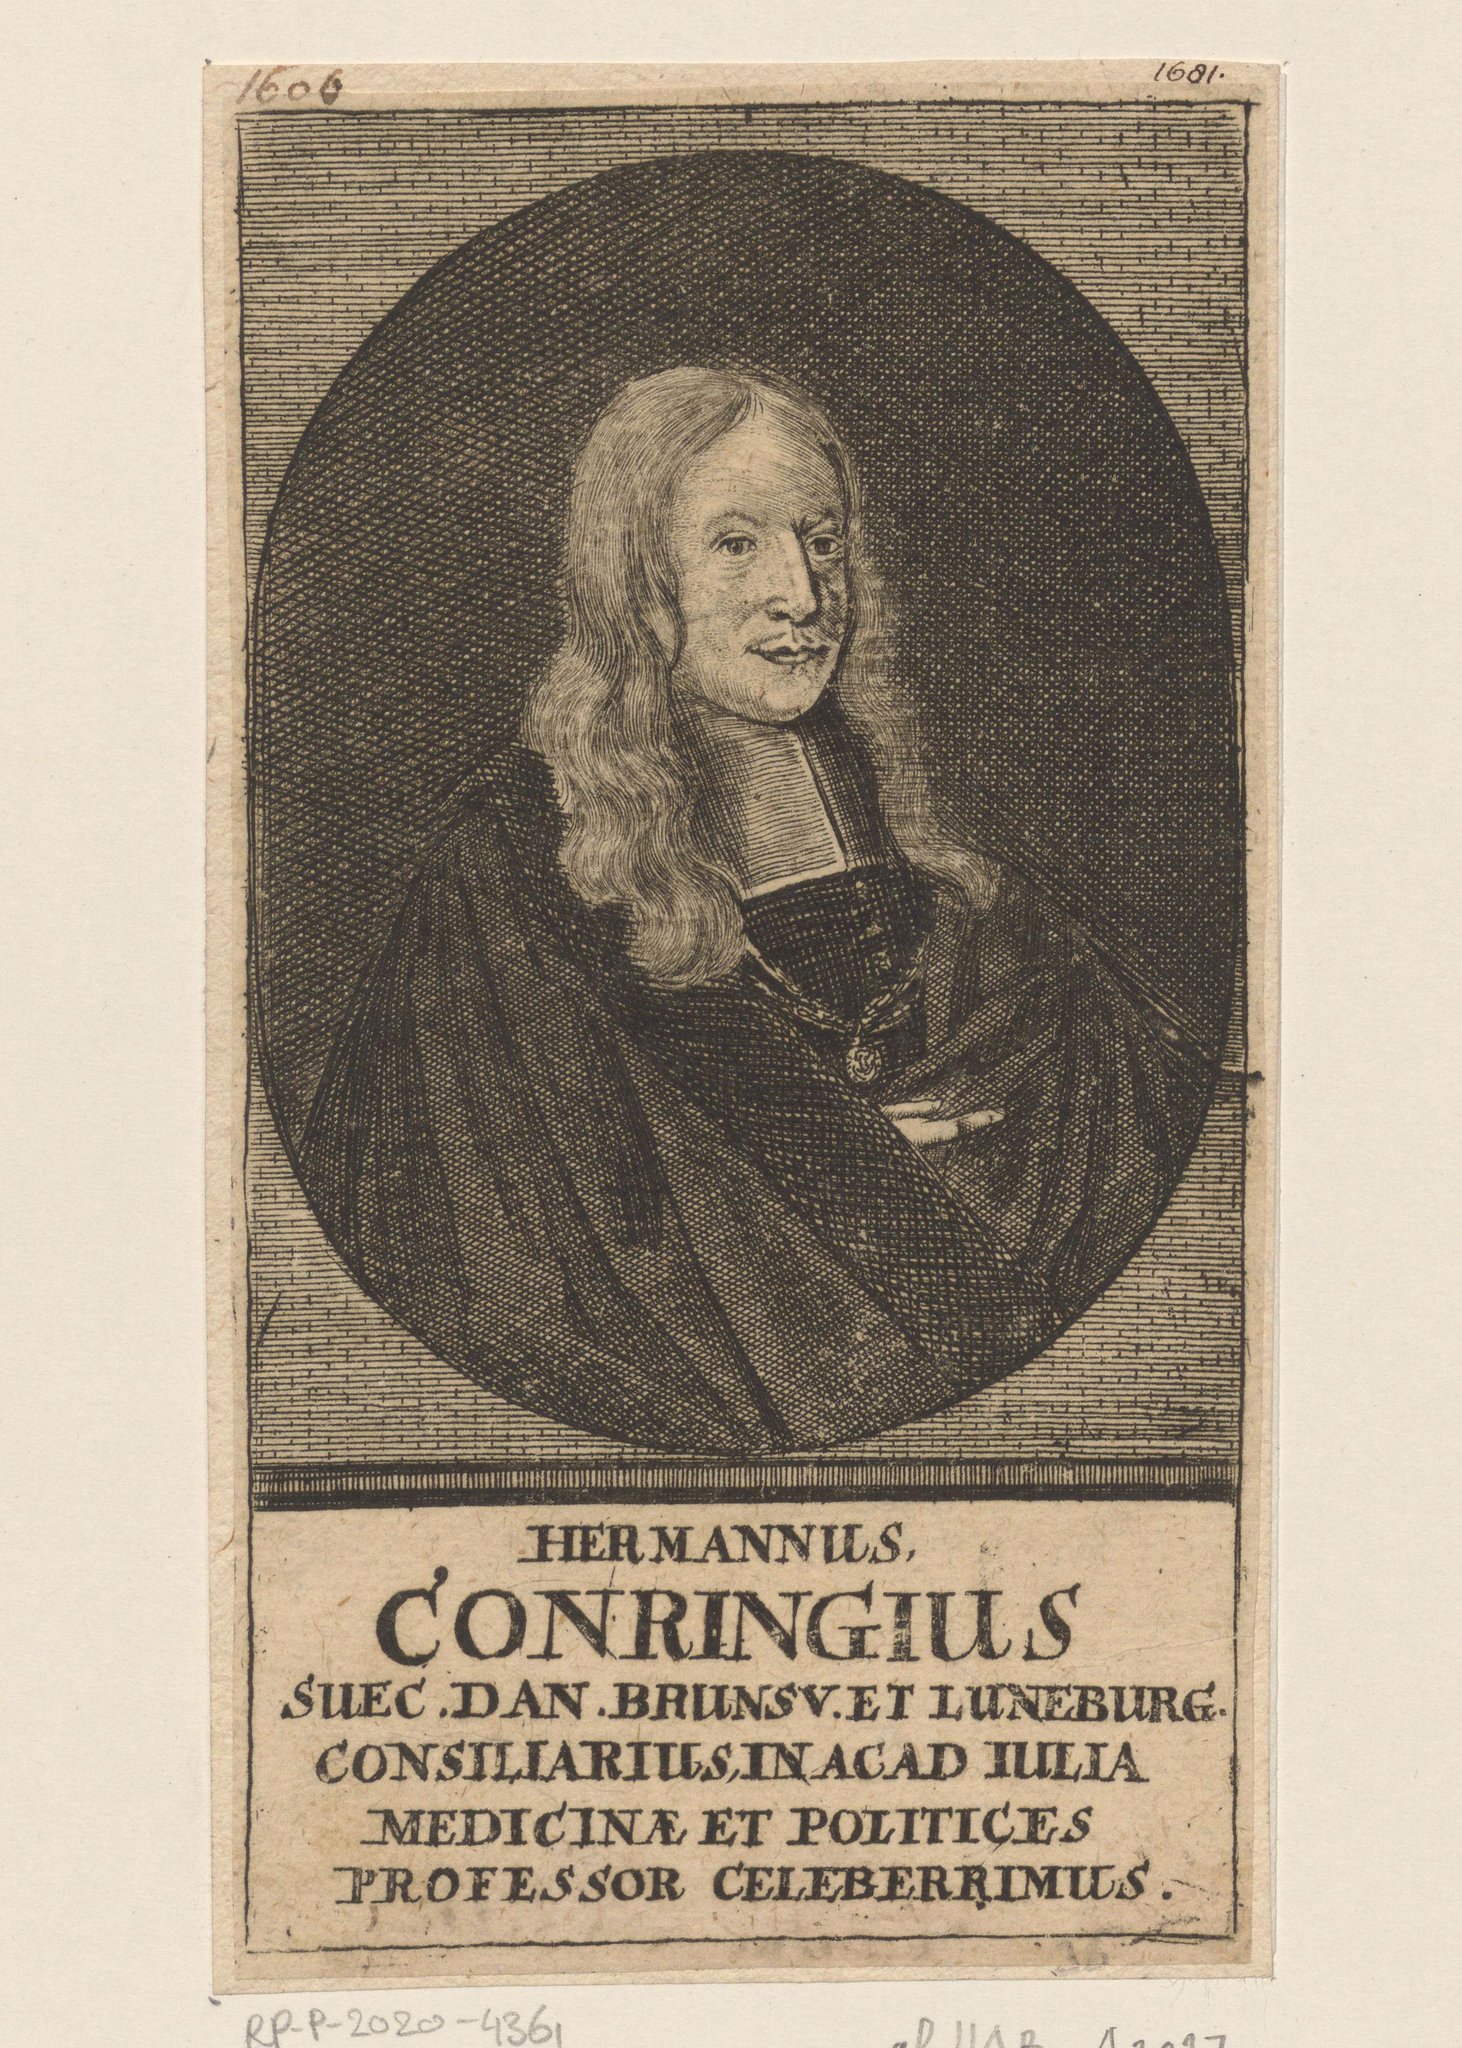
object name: print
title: Portret van Hermann Conring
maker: Anonymous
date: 1650-1749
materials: paper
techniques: engraving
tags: hermann conring, historical persons